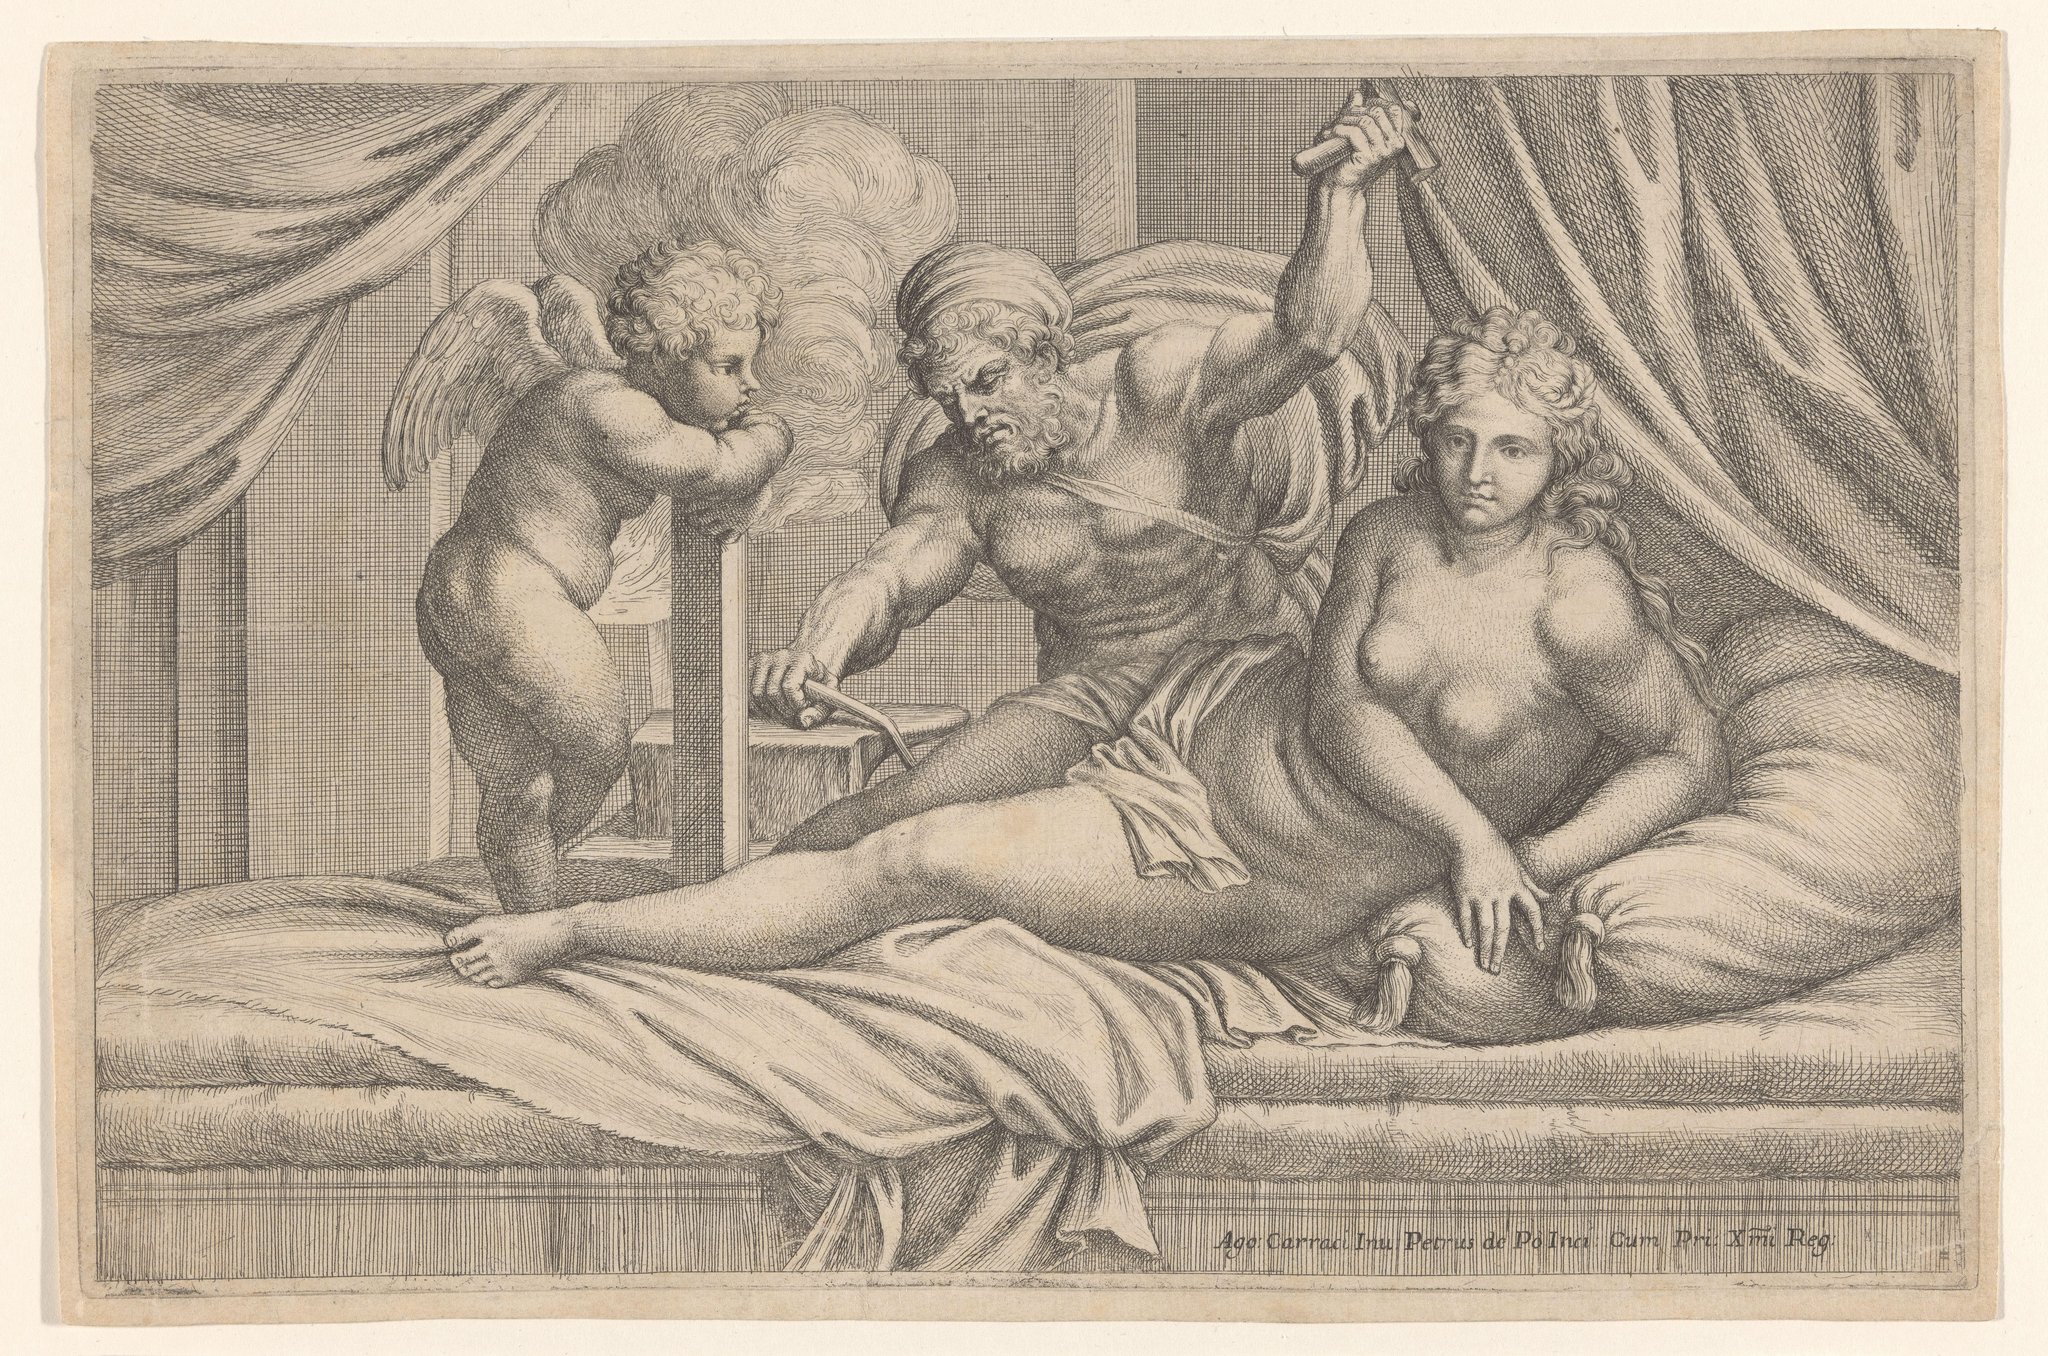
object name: print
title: Venus Reclining on a Bed in Vulcan's Forge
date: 1630-1650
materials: ink, paper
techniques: engraving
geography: naples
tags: vulcan forges cupid's wings and arrows, vulcan and venus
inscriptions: collector's mark: Lugt 2760, collector's mark: Lugt 2228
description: De naakte Venus ligt op bed naar de beschouwer toegewend. Achter haar Vulcanus hamerend op een stuk metaal op een aambeeld. Op het bed, links van Venus staat een verveeld kijkende Amor.